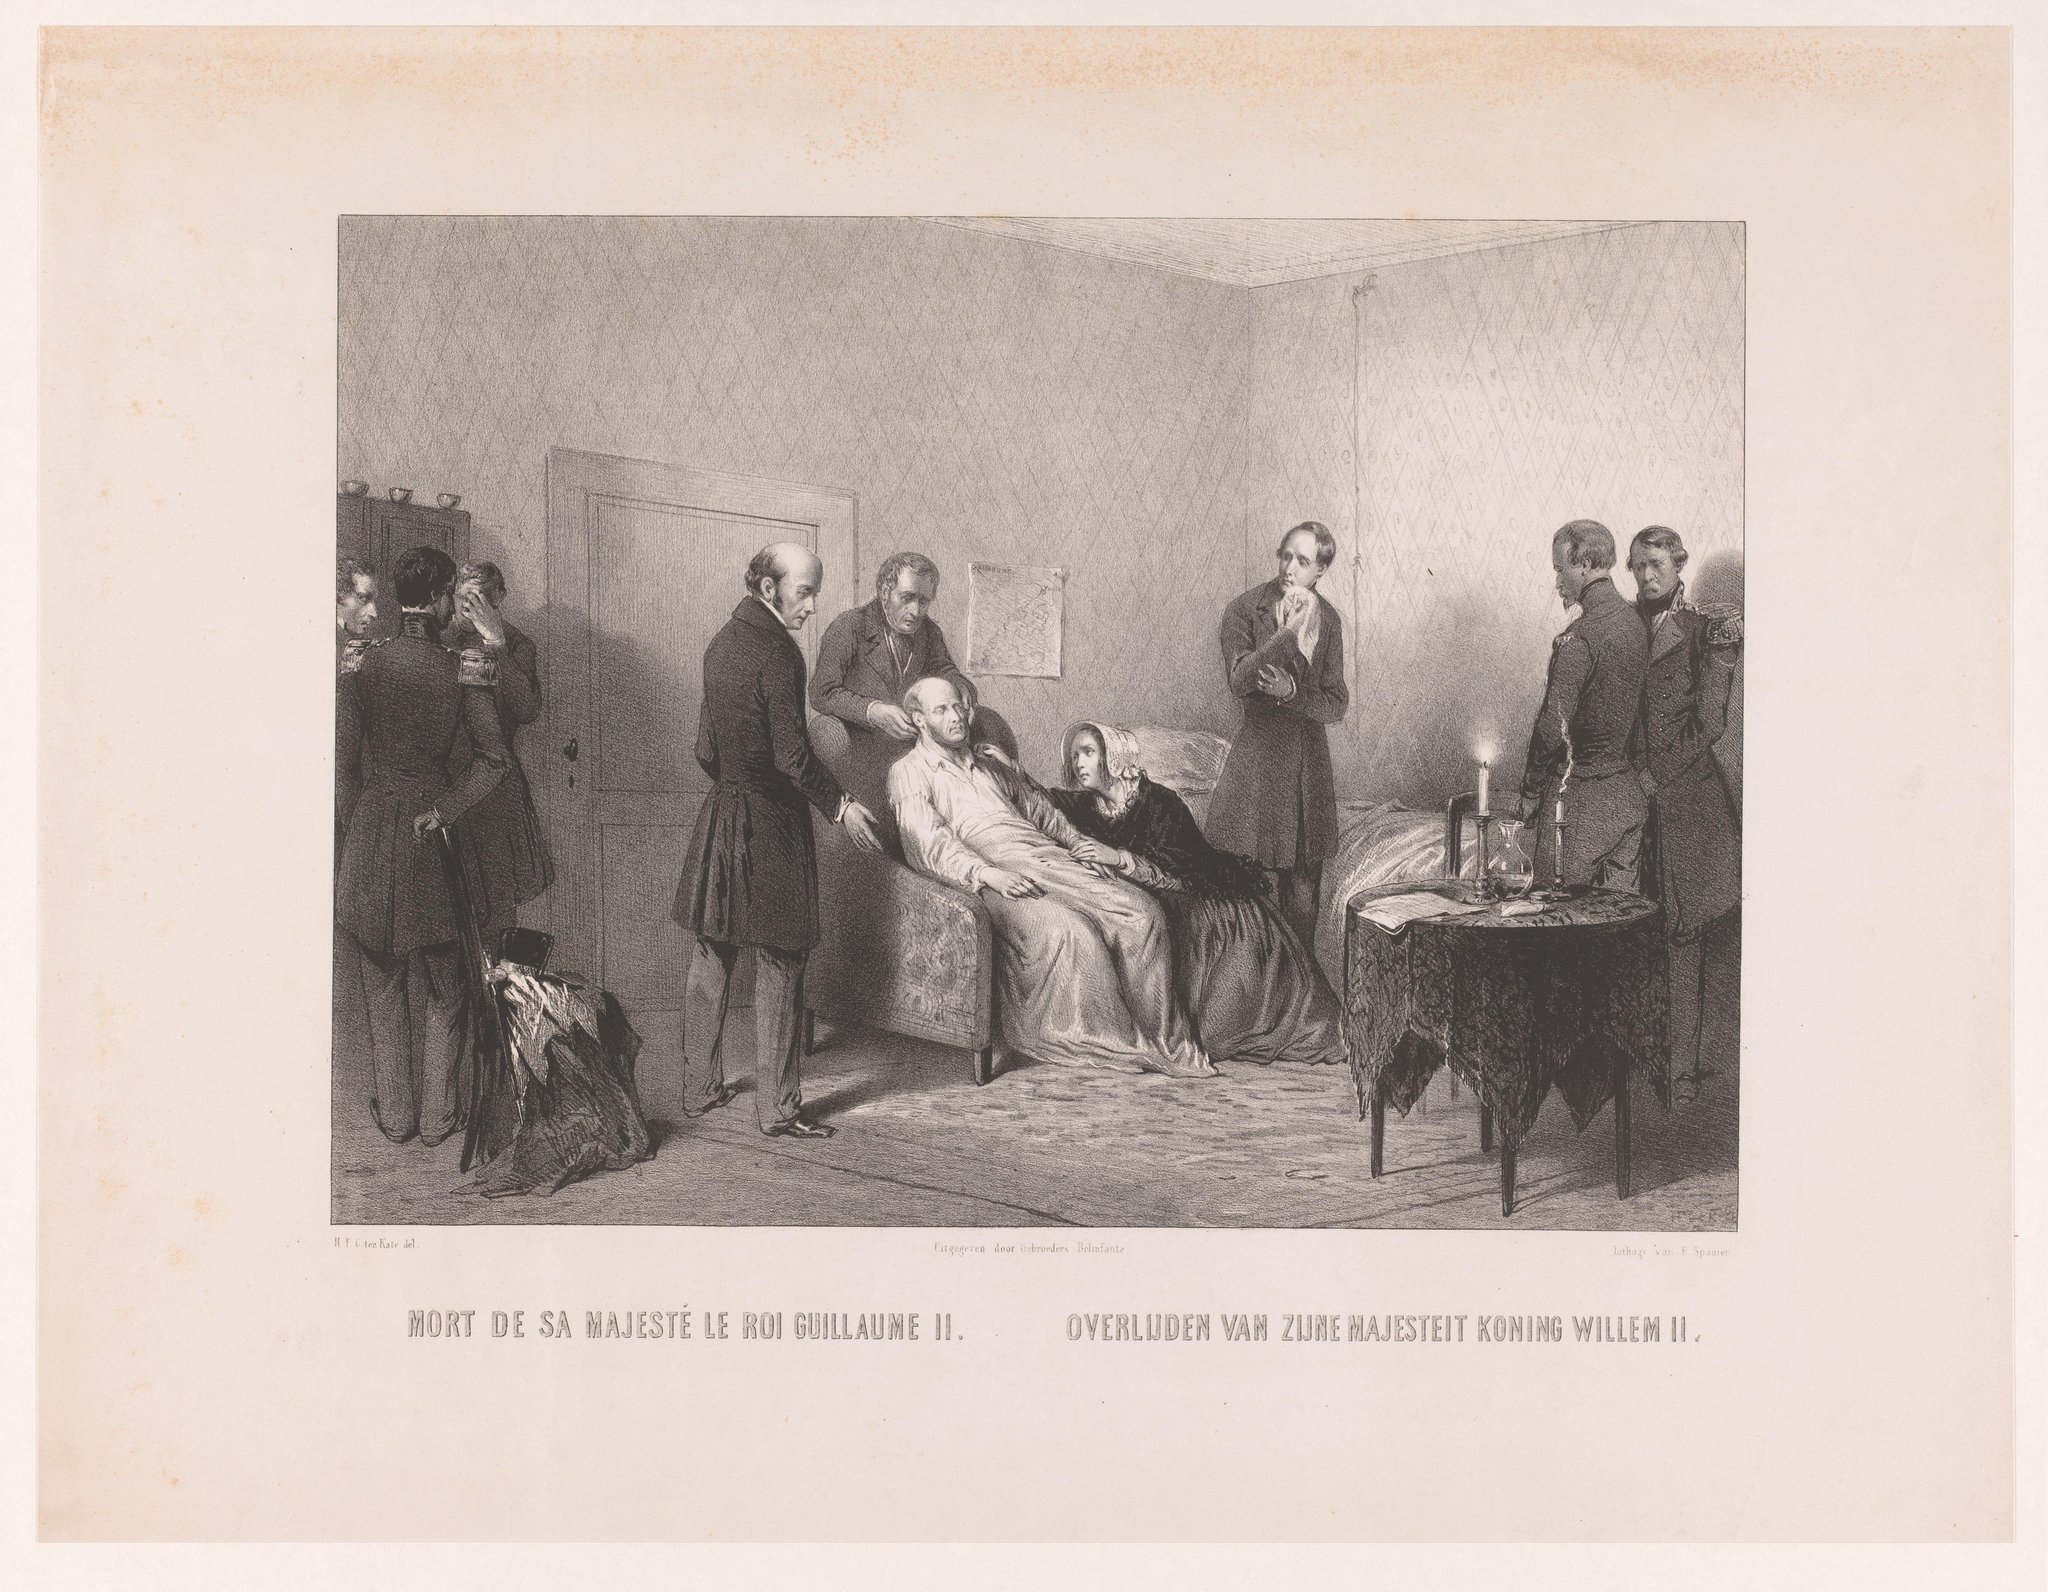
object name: print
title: Mort de sa majesté le roi Guillaume II / Overlijden van zijne majesteit koning Willem II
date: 1849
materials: paper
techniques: lithograph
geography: the hague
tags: anna paulowna romanowa, the hague, william ii of the netherlands, hendrik (prins der nederlanden), deathbed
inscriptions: collector's mark: Lugt 2228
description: Het overlijden van koning Willem II in Tilburg op 17 maart 1849. De koning sterft zittend in een stoel in een kamer, aan zijn voeten knielt zijn echtgenote Anna Paulowna. Achter haar staat prins Hendrik, rechts de adjudanten Coehoorn en Merkes. Links van de koning de kamerheer Matthijs, de arts Everard. Meer naar links de artsen Maes en Van Hees en de kamerheer Aerts.